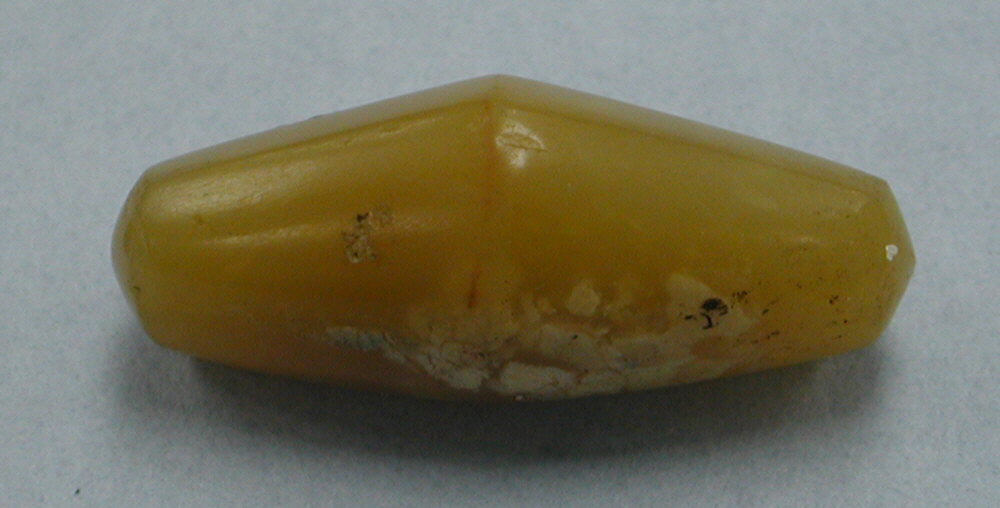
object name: ritual stone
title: Stone Pulidor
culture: mexican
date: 1501-1600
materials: stone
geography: mexico